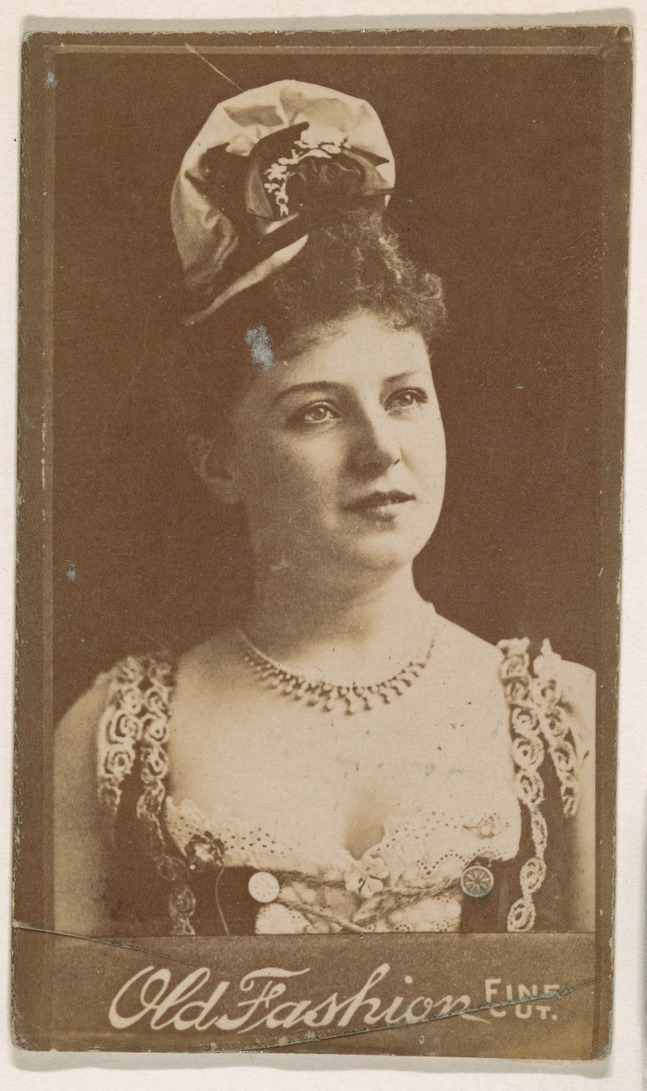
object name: photograph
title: Actress wearing floral hat, from the Actresses series (N664) promoting Old Fashion Fine Cut Tobacco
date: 1888-1890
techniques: albumen silver print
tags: portraits,women,actresses